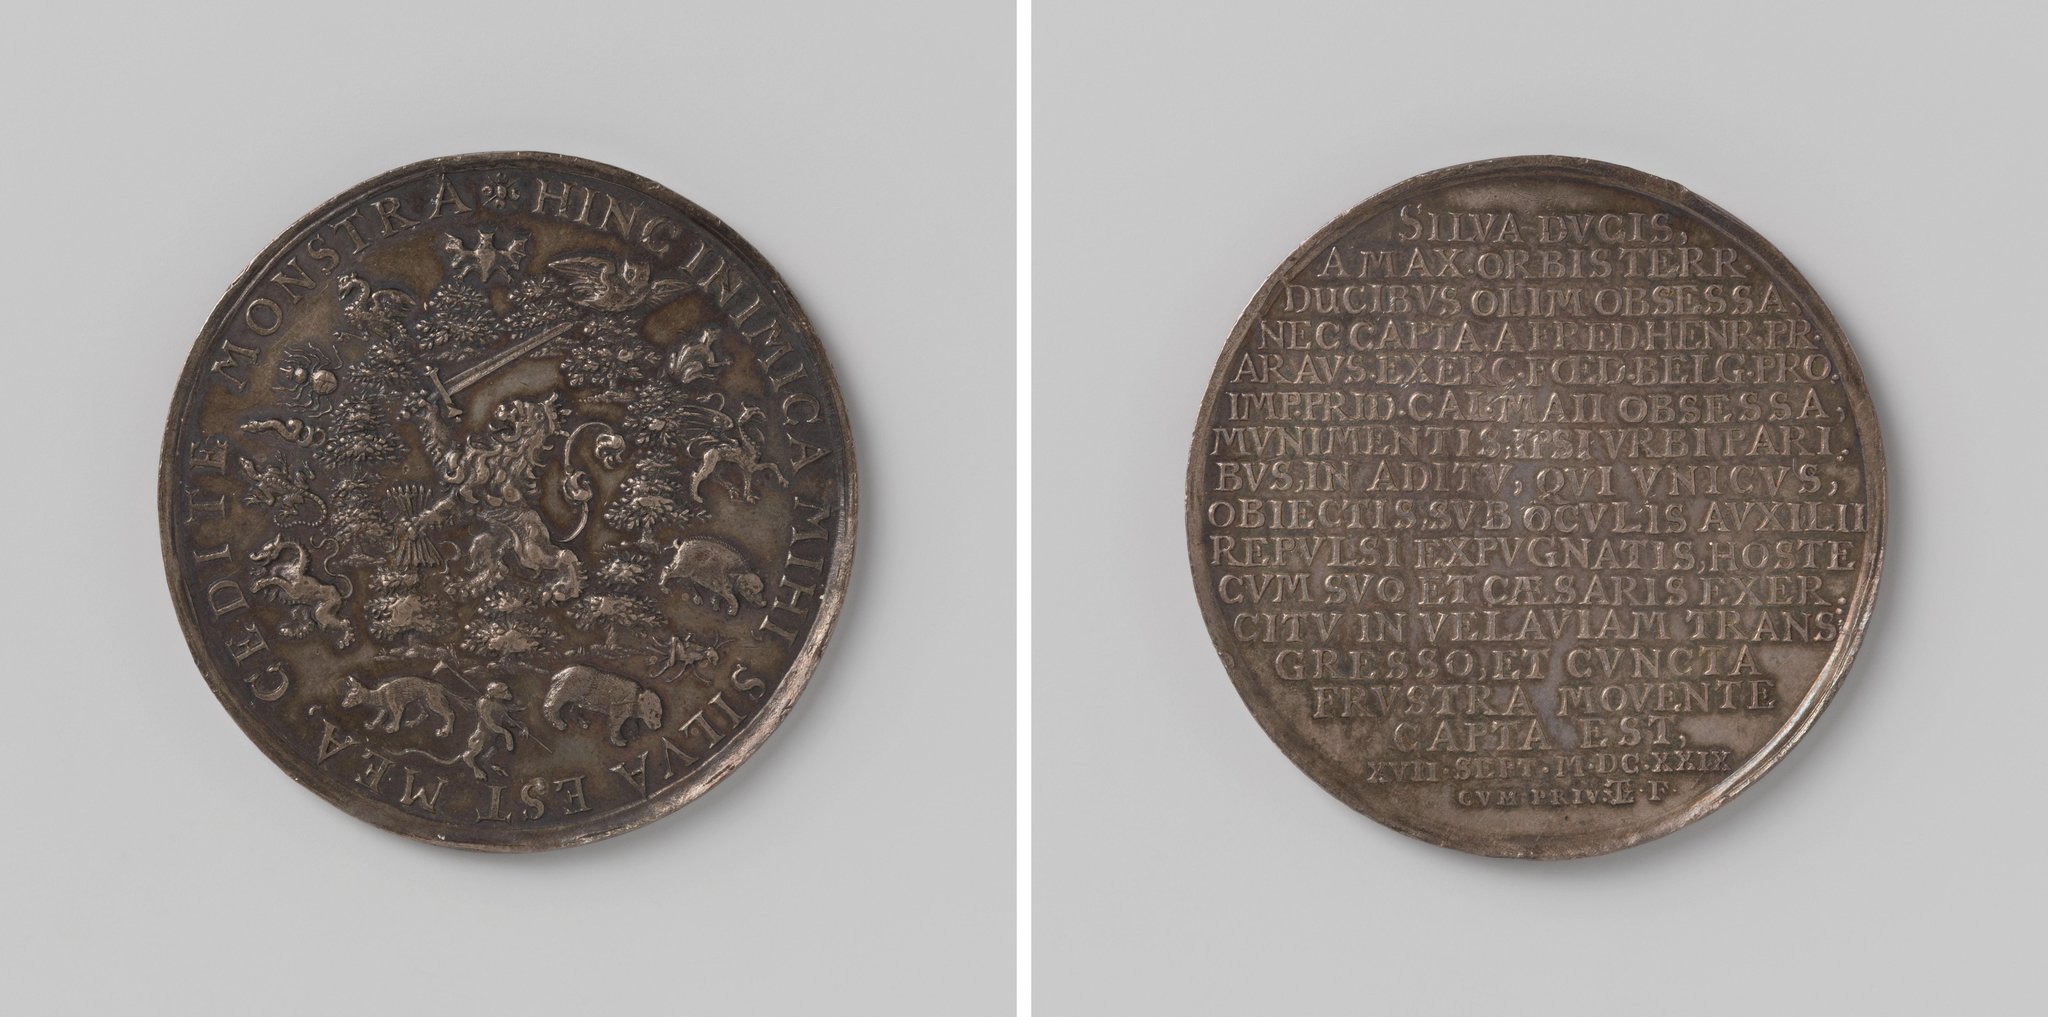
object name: triomfpenning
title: Inname van 's Hertogenbosch door Frederik Hendrik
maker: laurens van teylingen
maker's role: mintmaster, print maker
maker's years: -1637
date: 1629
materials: silver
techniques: striking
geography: west frisia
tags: the hague, frederick henry (prince of orange), den bosch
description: Zilveren penning. Voorzijde: gekroonde leeuw met zwaard verdrijft verschillende dieren uit bos, binnen omschrift. Keerzijde: opschrift